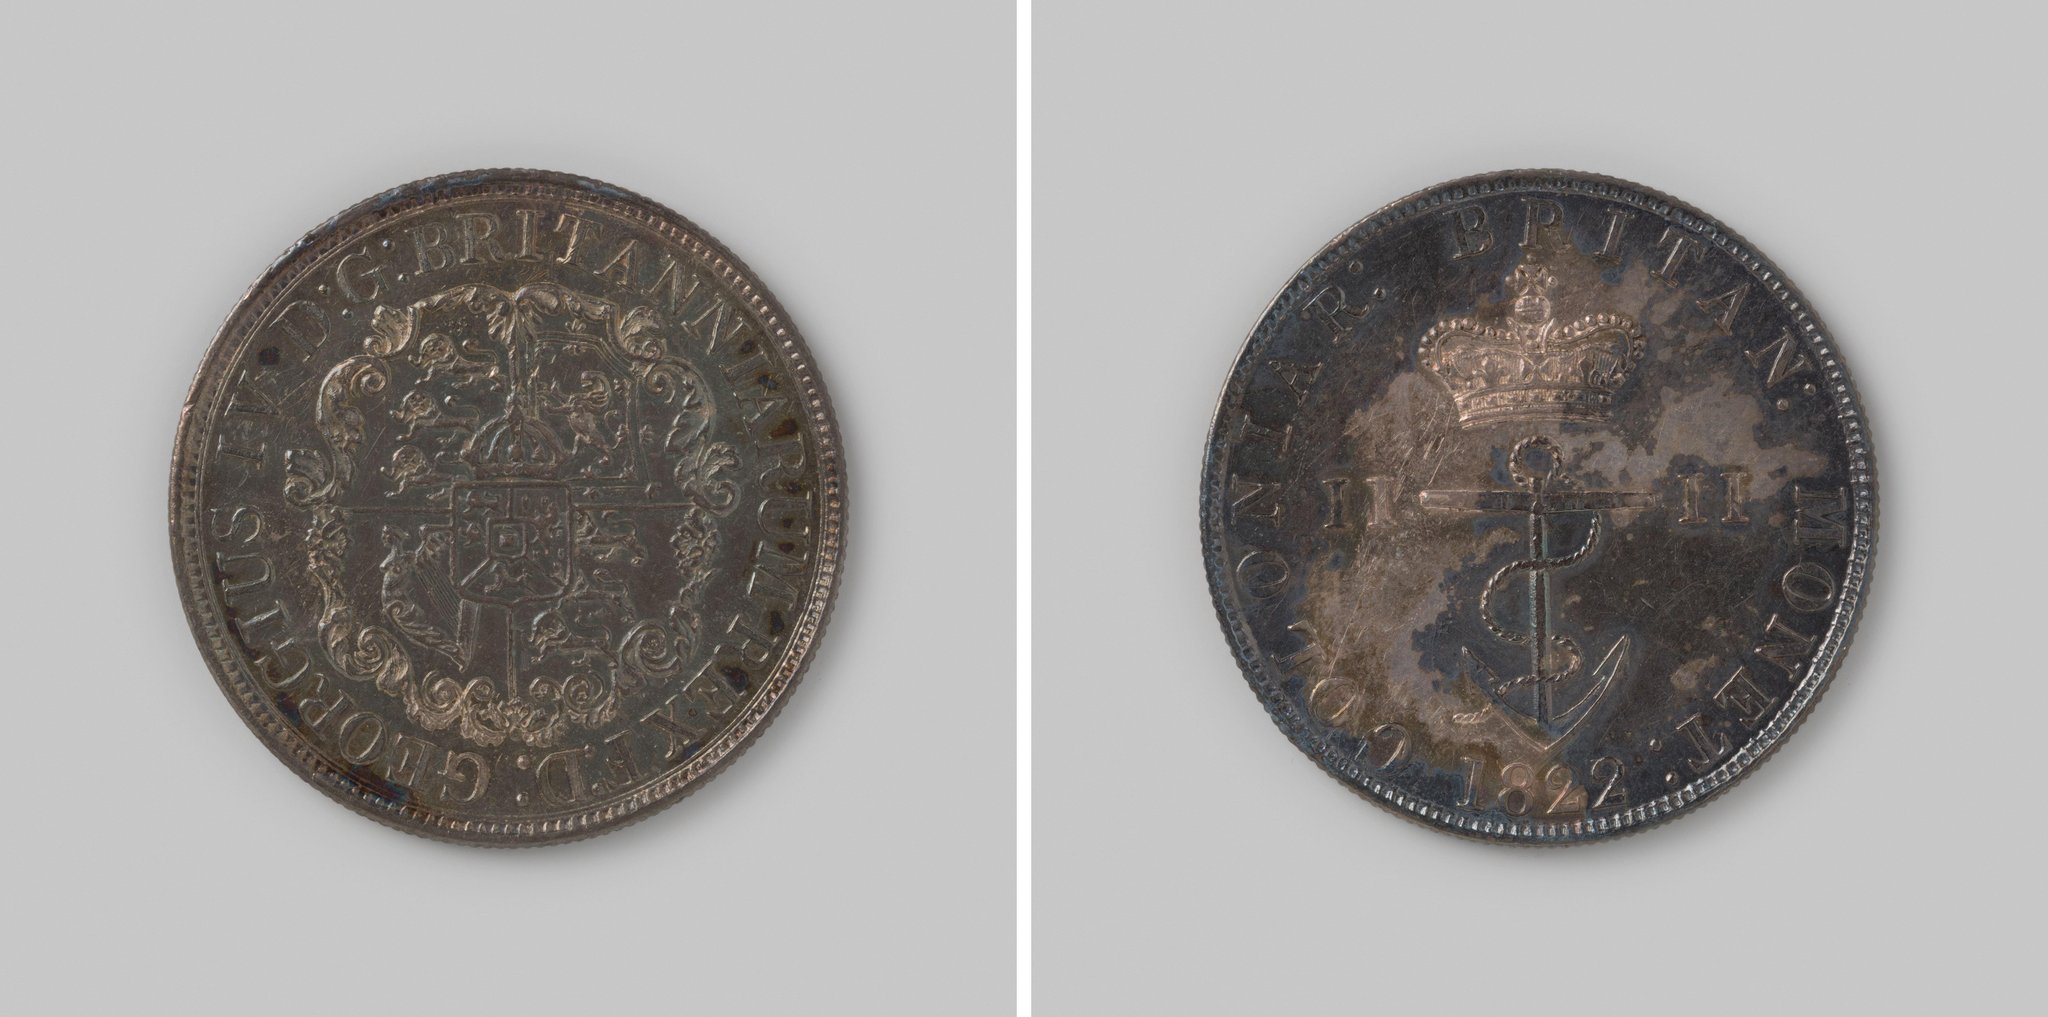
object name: coin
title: ½ dollar voor Brits West-Indië van koning George IV, 1822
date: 1822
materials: silver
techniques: striking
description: Zilveren munt. Voorzijde: versierd samengesteld wapenschild. Keerzijde: tussen waarde-aanduidingen II [voor: ½] en II anker met touw, waarboven kroon.Daaronder jaartal. Kartelrand.